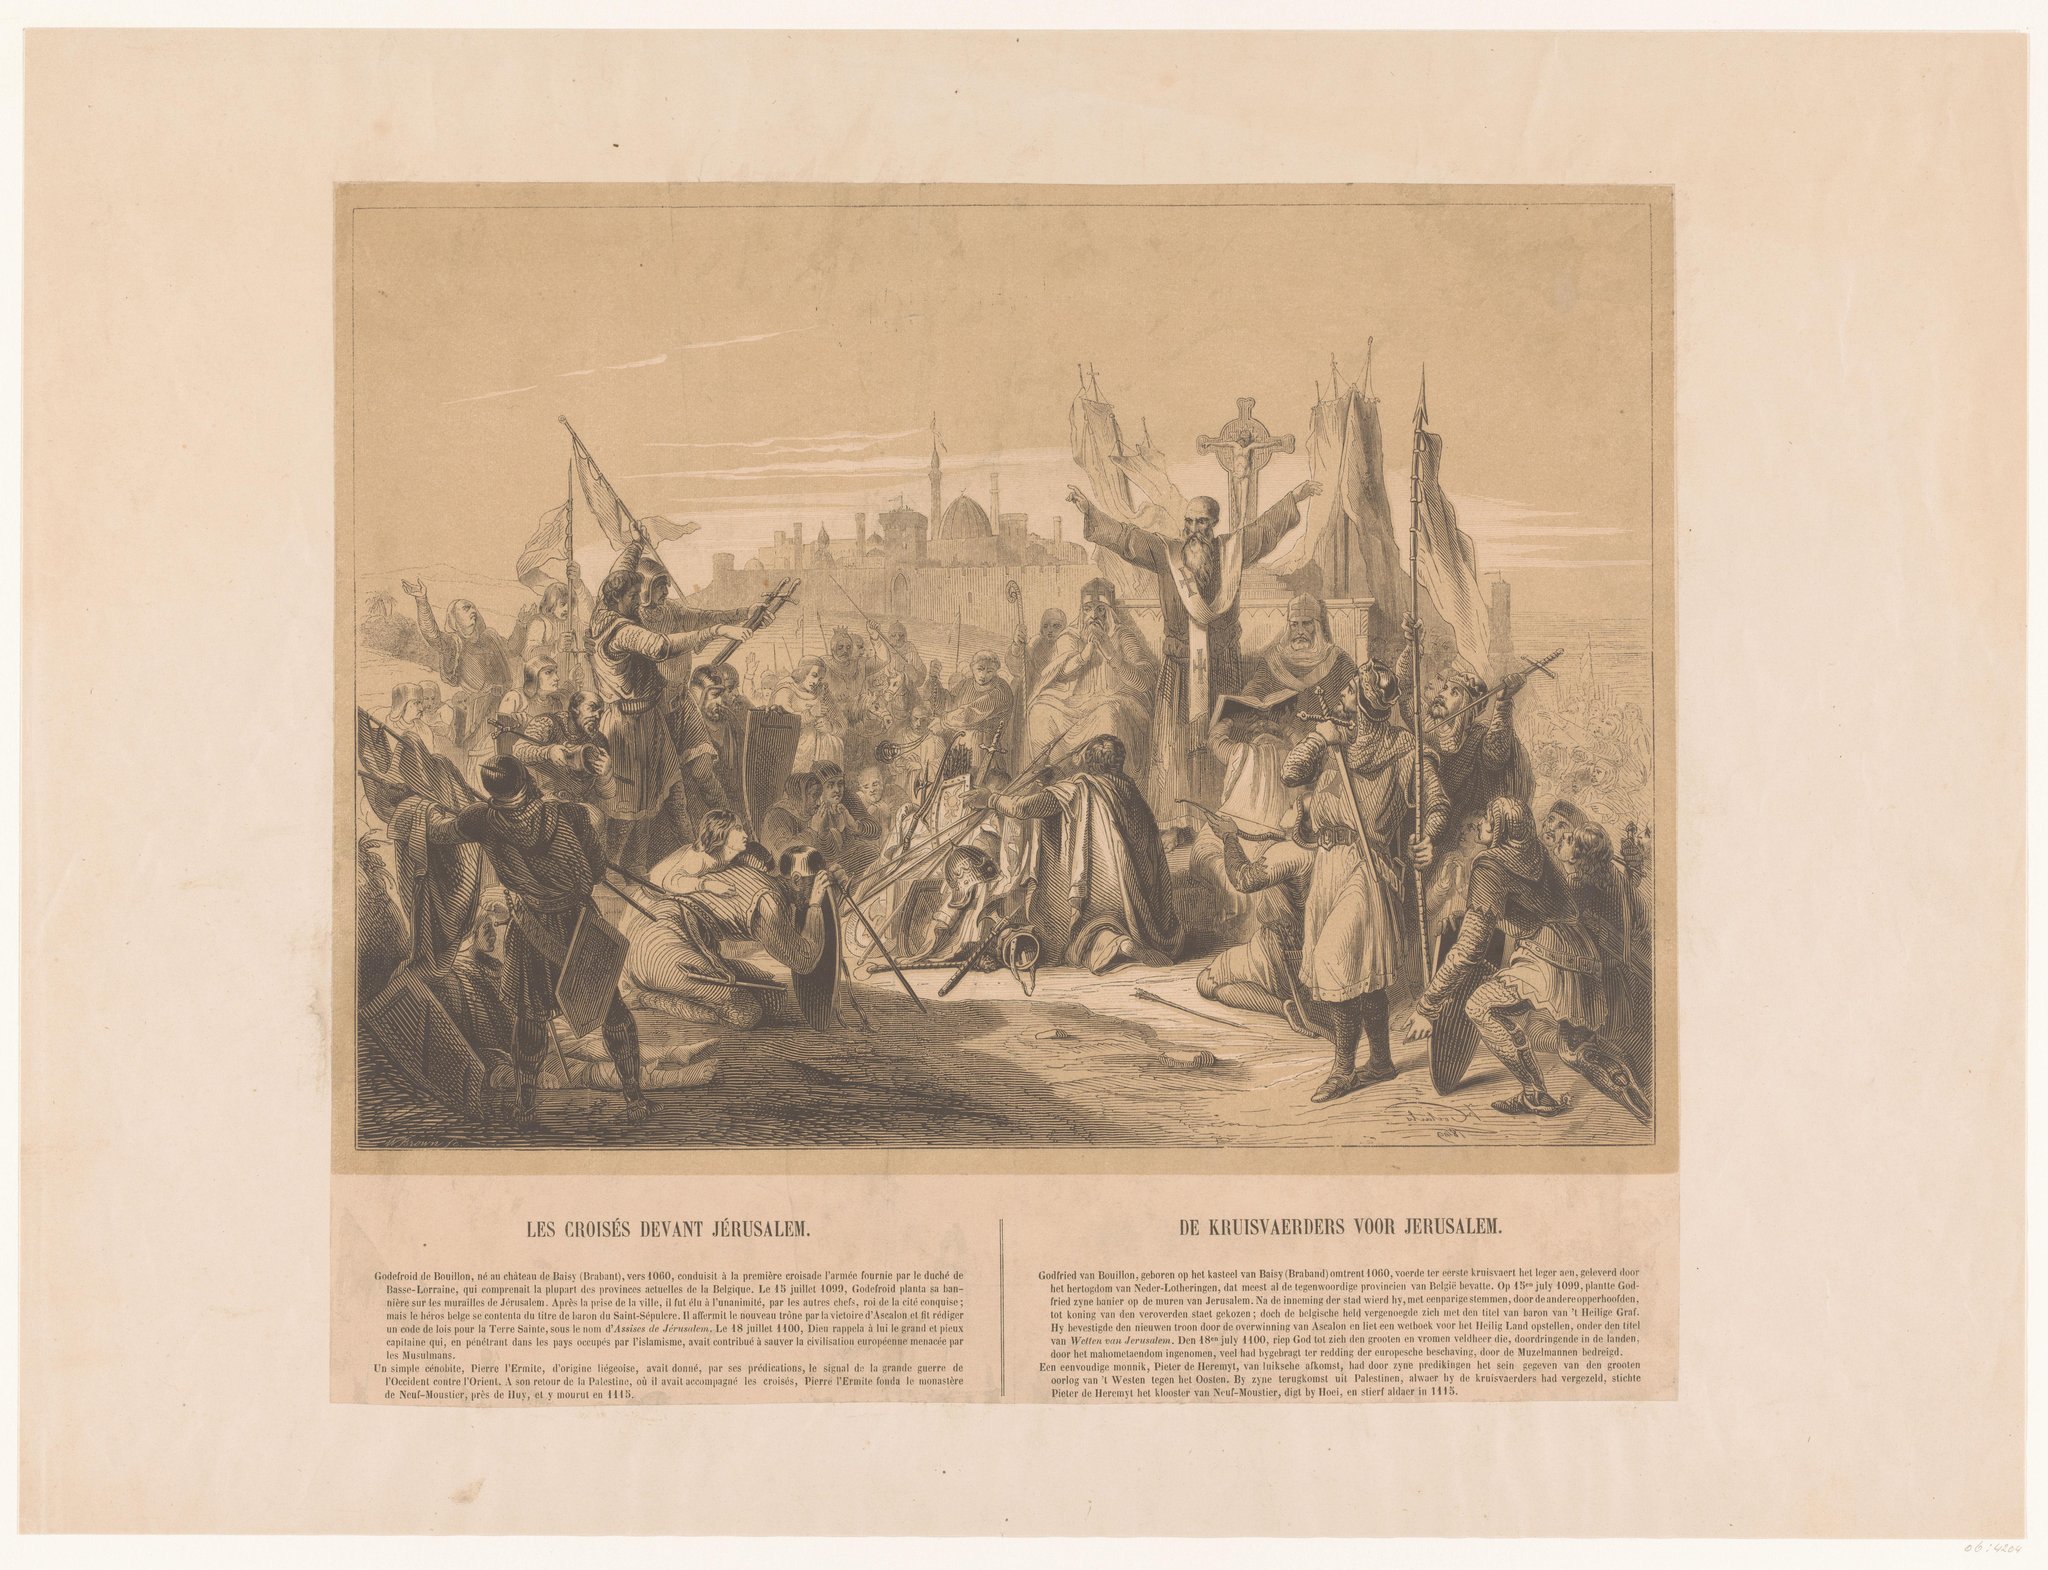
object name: book illustration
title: Les Croisés devant Jérusalem / De Kruisvaerders voor Jerusalem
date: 1849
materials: paper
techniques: letterpress printing, engraving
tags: city-view, and landscape with man-made constructions, militant proselytizing: religious war, crusade, etc.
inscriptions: mark: ‘[...]tails’, collector's mark: Lugt 2228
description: Tekst in het Frans en Nederlands onder de voorstelling.